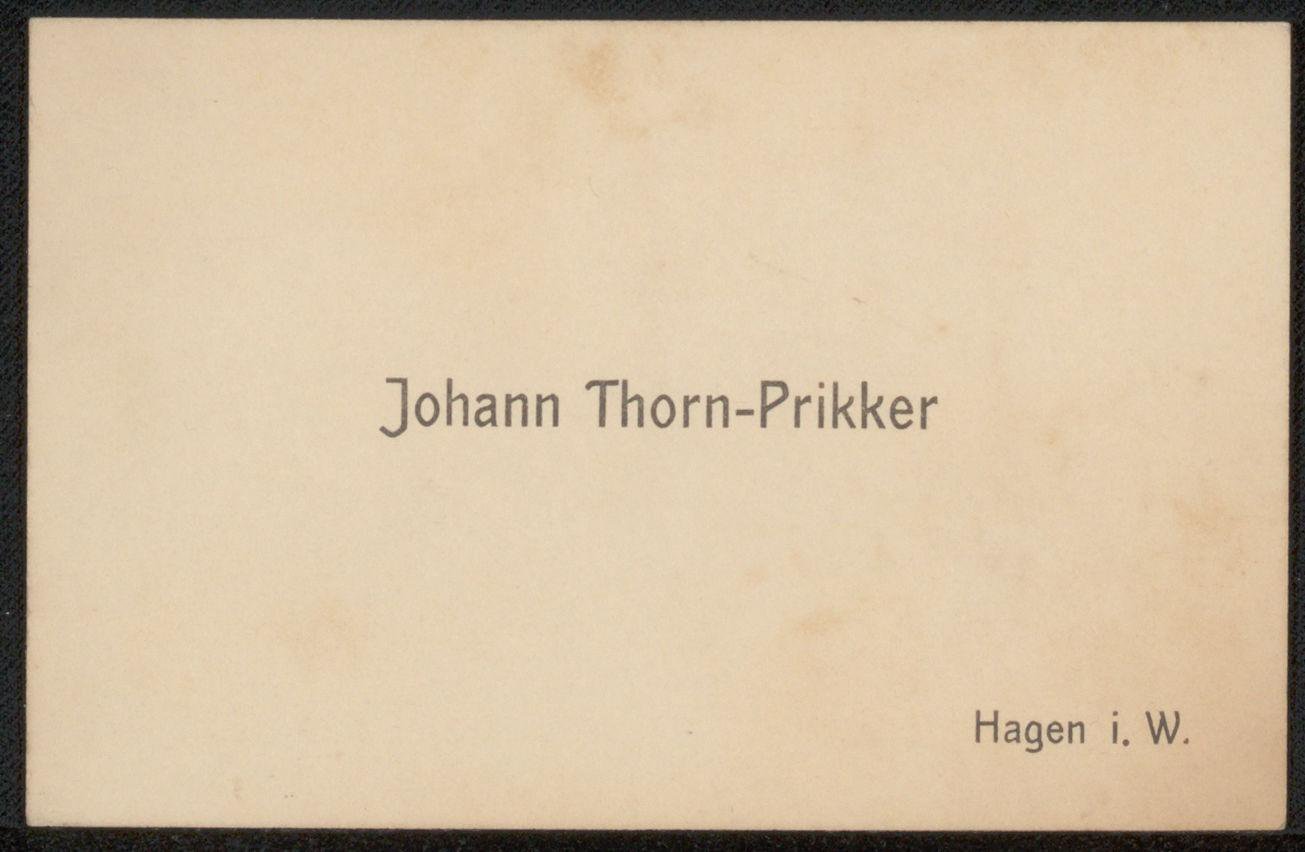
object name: visiting card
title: Visitekaartje aan Philip Zilcken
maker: johan thorn prikker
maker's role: draughtsman, print maker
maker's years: 1868-1932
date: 1878-1932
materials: cardboard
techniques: printing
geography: hagen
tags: painter, philip zilcken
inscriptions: collector's mark: ‘RPK’